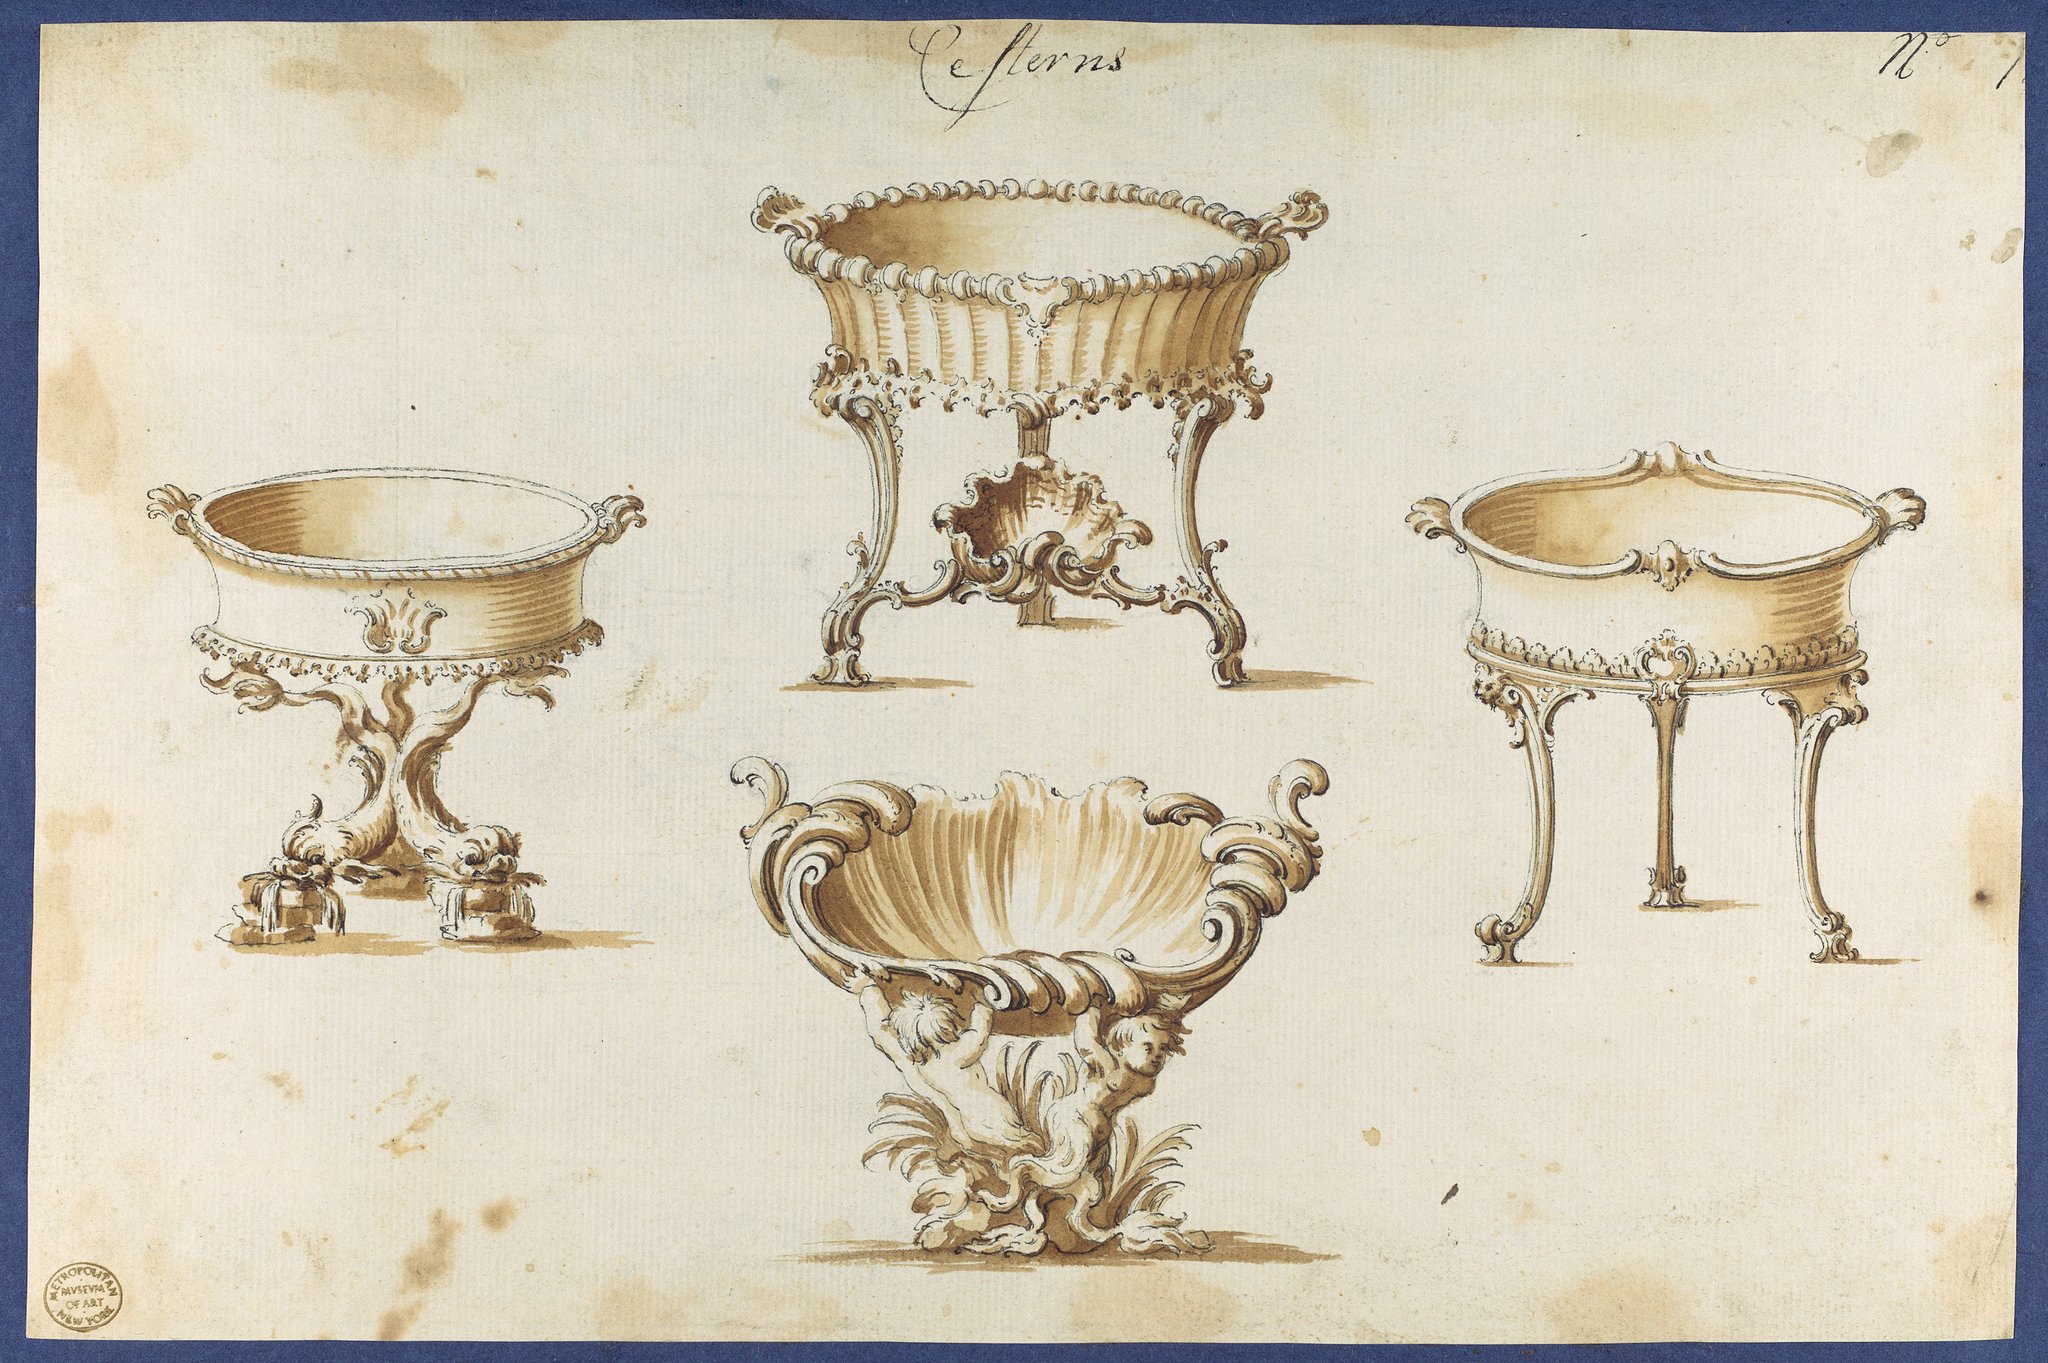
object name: drawing ornament architecture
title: Cisterns, from Chippendale Drawings, Vol. II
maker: thomas chippendale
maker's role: artist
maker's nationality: british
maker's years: 1718-1779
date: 1760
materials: ink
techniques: wash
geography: london